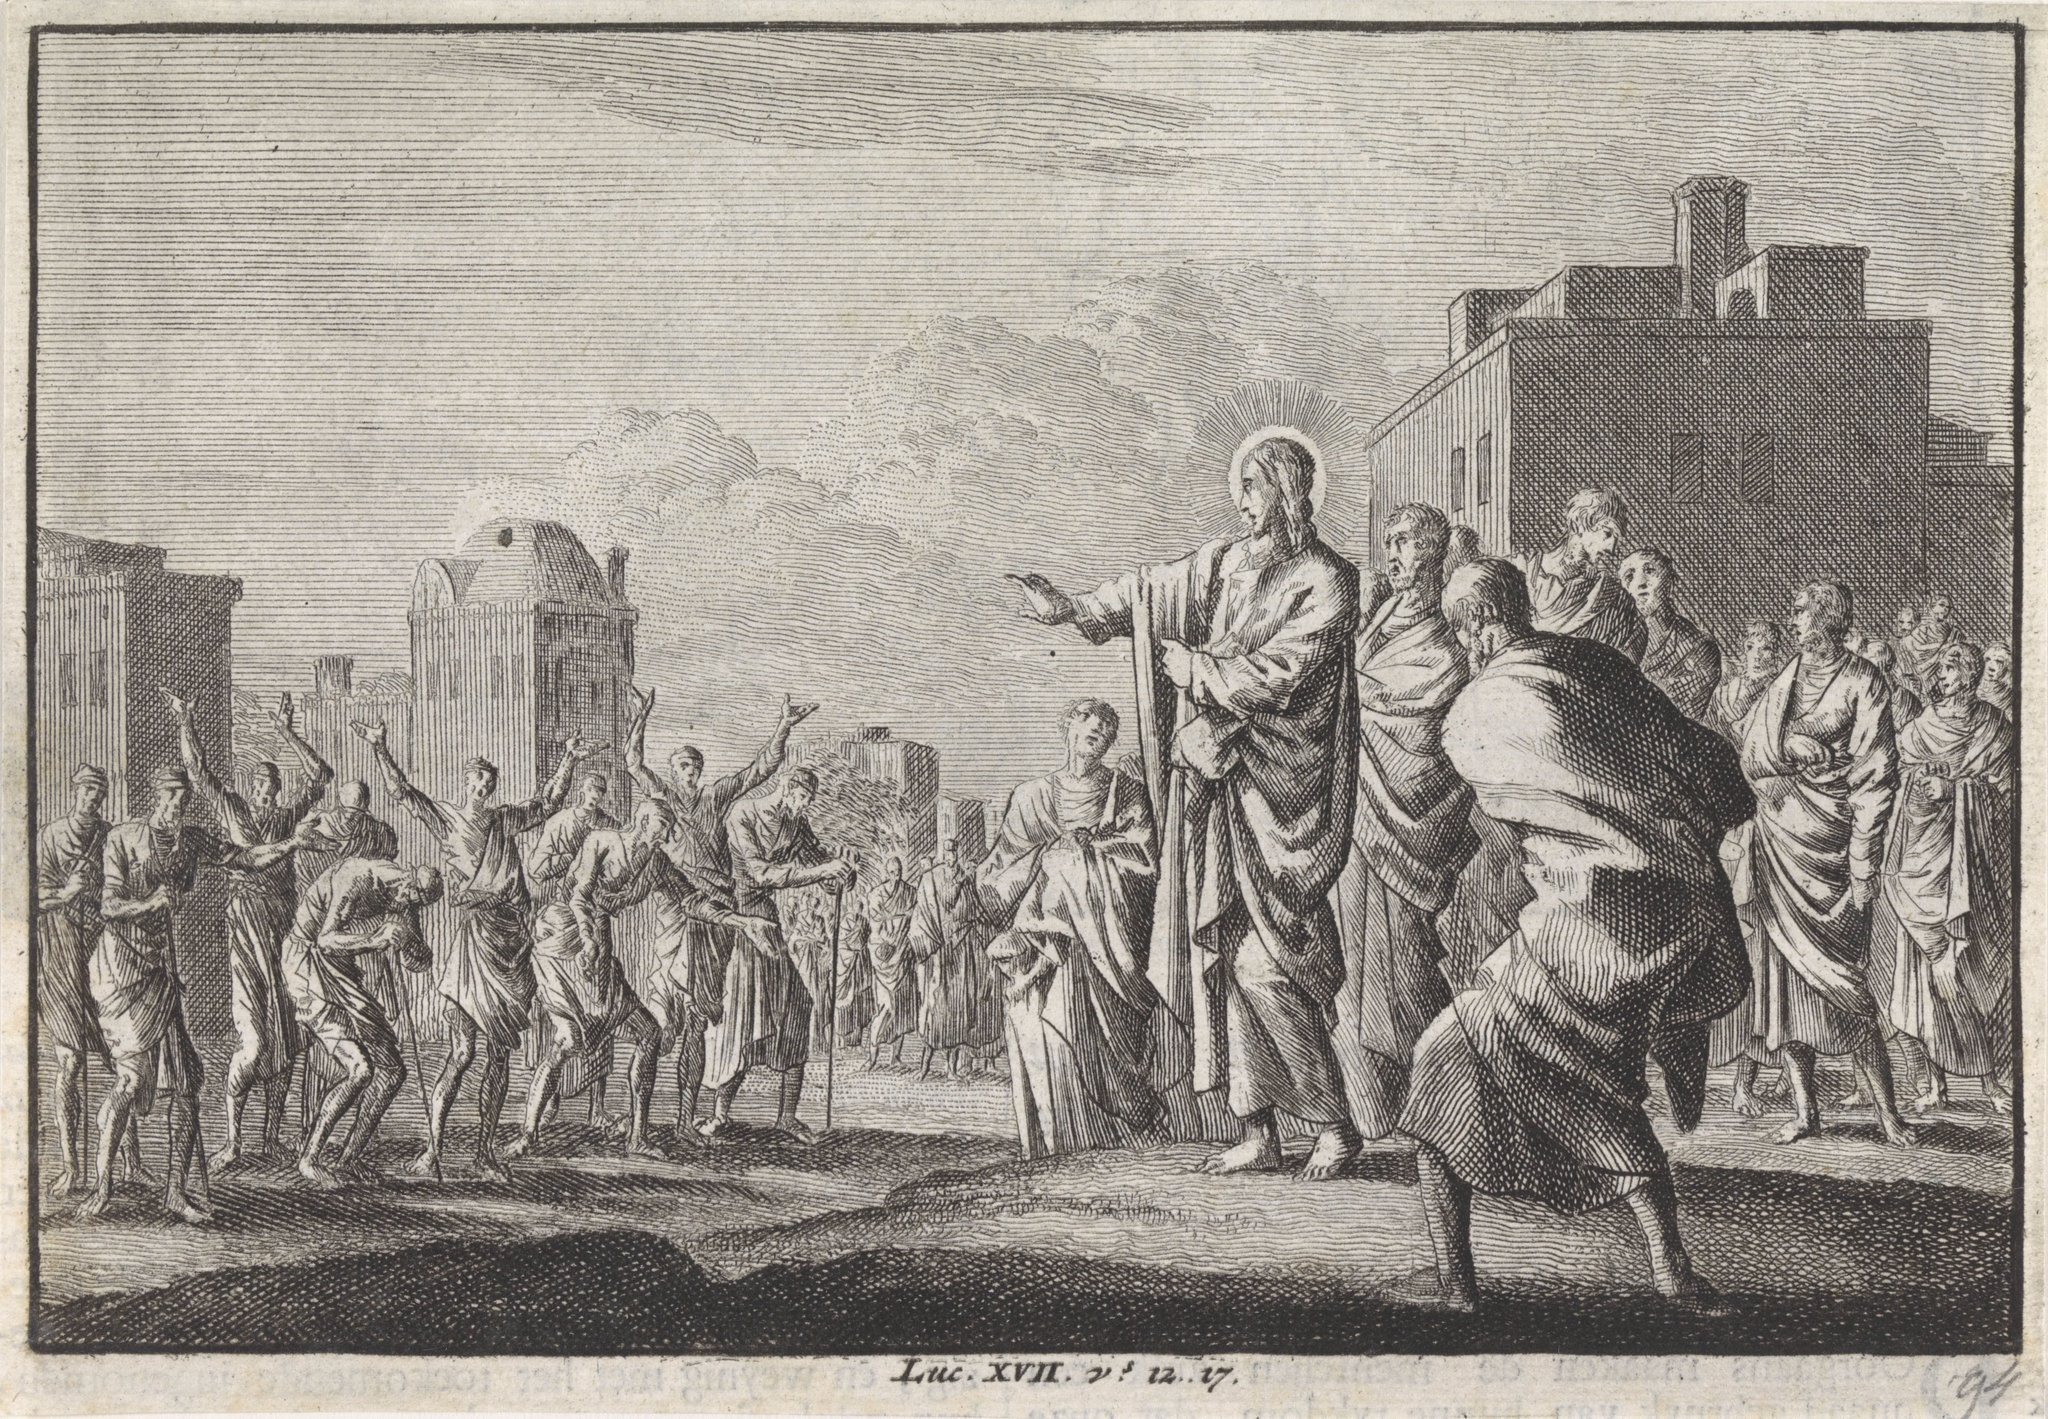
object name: print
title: Christus en de tien melaatsen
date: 1703-1762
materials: paper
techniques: etching, letterpress printing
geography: haarlem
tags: christ sends ten lepers to the priest (luke 17:11-19)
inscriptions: collector's mark: Lugt 2228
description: De prent komt een eerste keer voor als boekillustratie voor David Martin. Historie des Ouden en Nieuwen Testaments. Amsterdam, Pieter Mortier, 1703. Deel II. De boekillustraties voor de Mortierbijbel hebben verschillende staten en kopieën, waarbij de chronologische volgorde moeilijk te achterhalen valt. Als boekillustraties werden ze bovendien herhaaldelijk opnieuw gebruikt voor andere boekwerken.